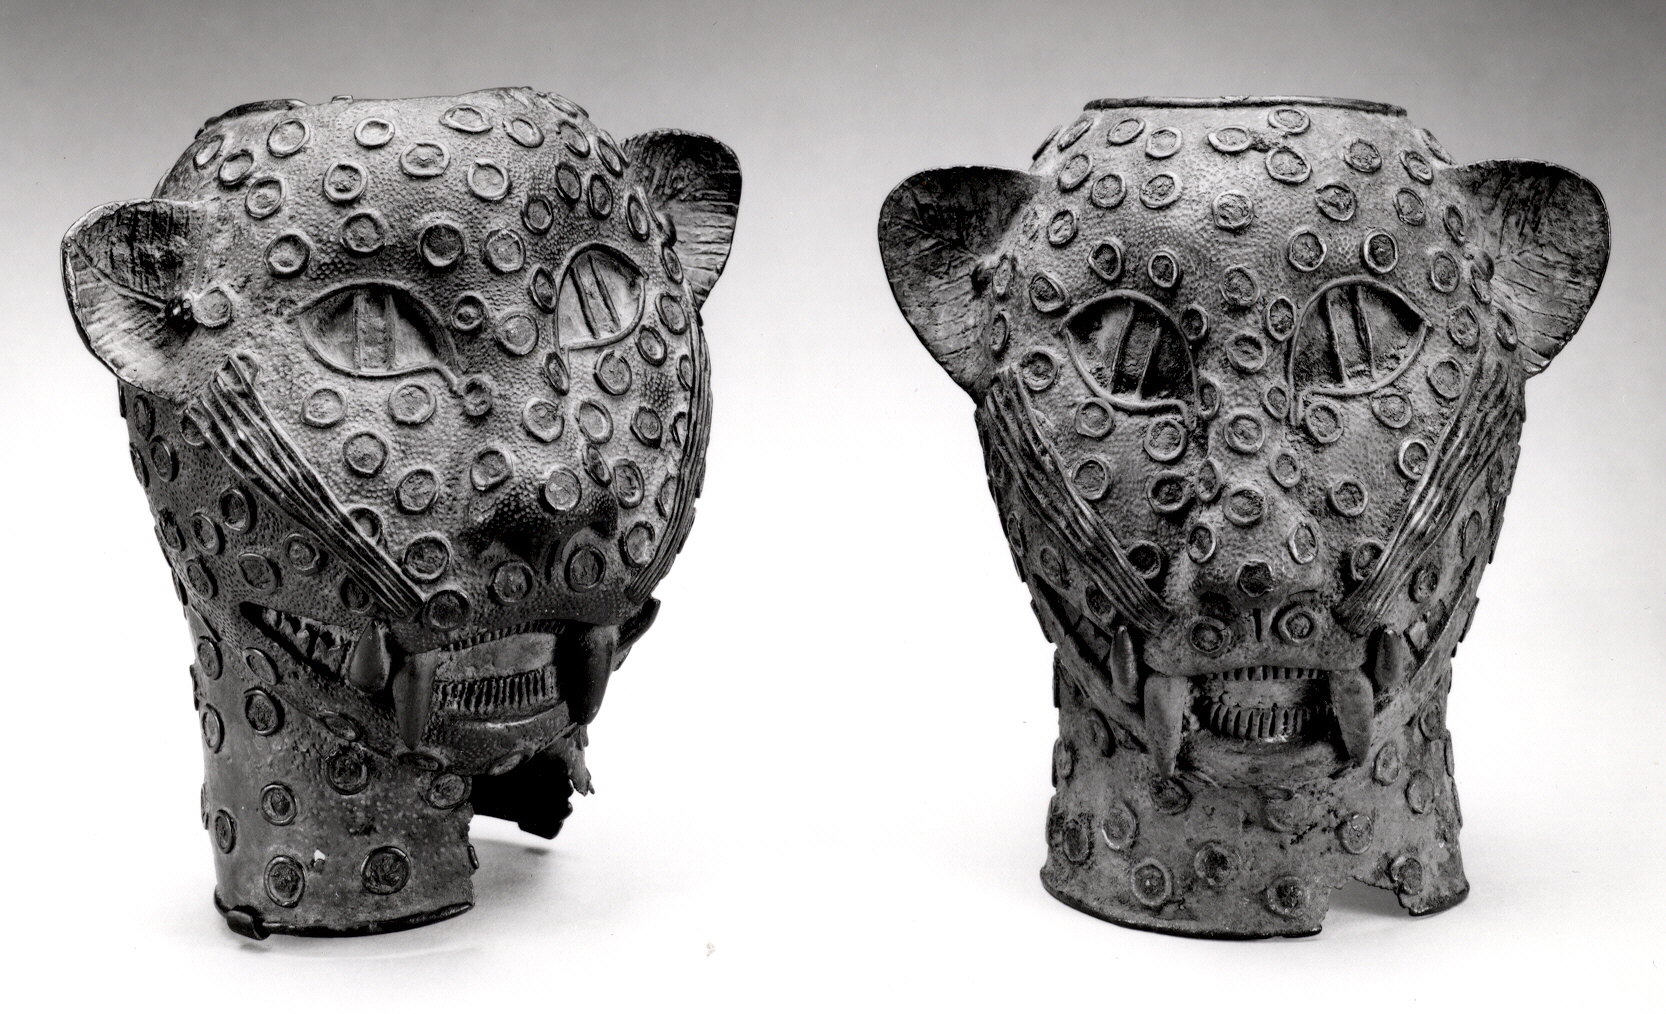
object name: head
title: Figure: Leopard Head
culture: edo period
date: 1701-1900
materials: brass, iron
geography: nigeria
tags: leopards